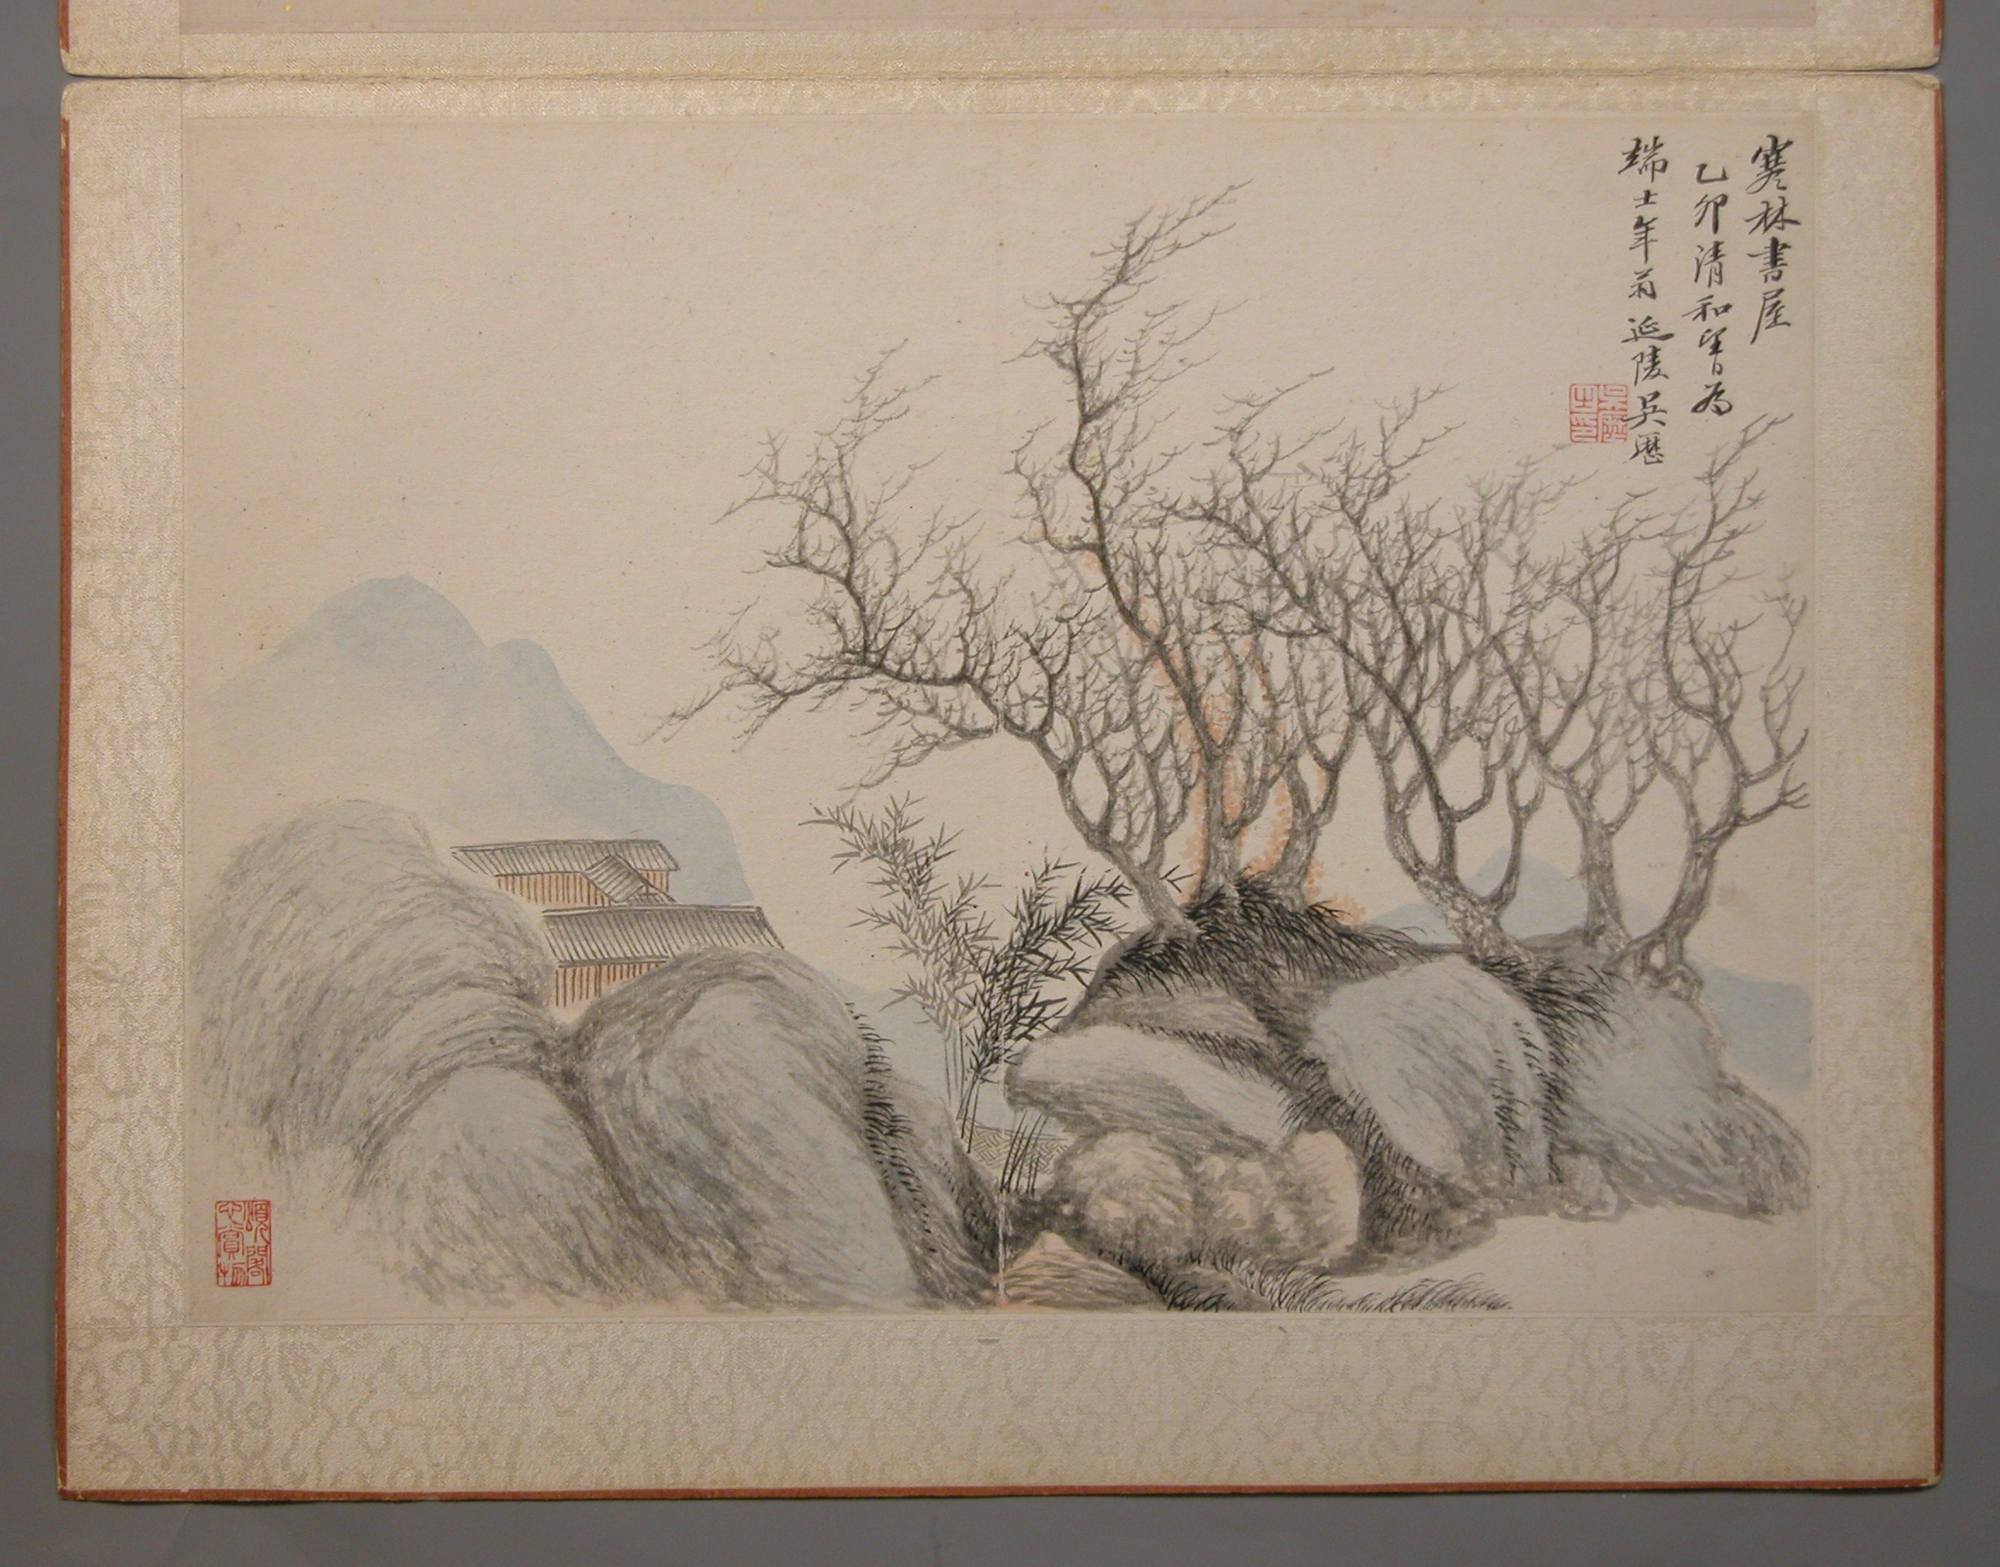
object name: album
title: Landscapes Painted for Wang Kui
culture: chinese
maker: wang jian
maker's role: artist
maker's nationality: chinese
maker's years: 1609-1677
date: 1674-1676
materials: ink, paper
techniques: painting